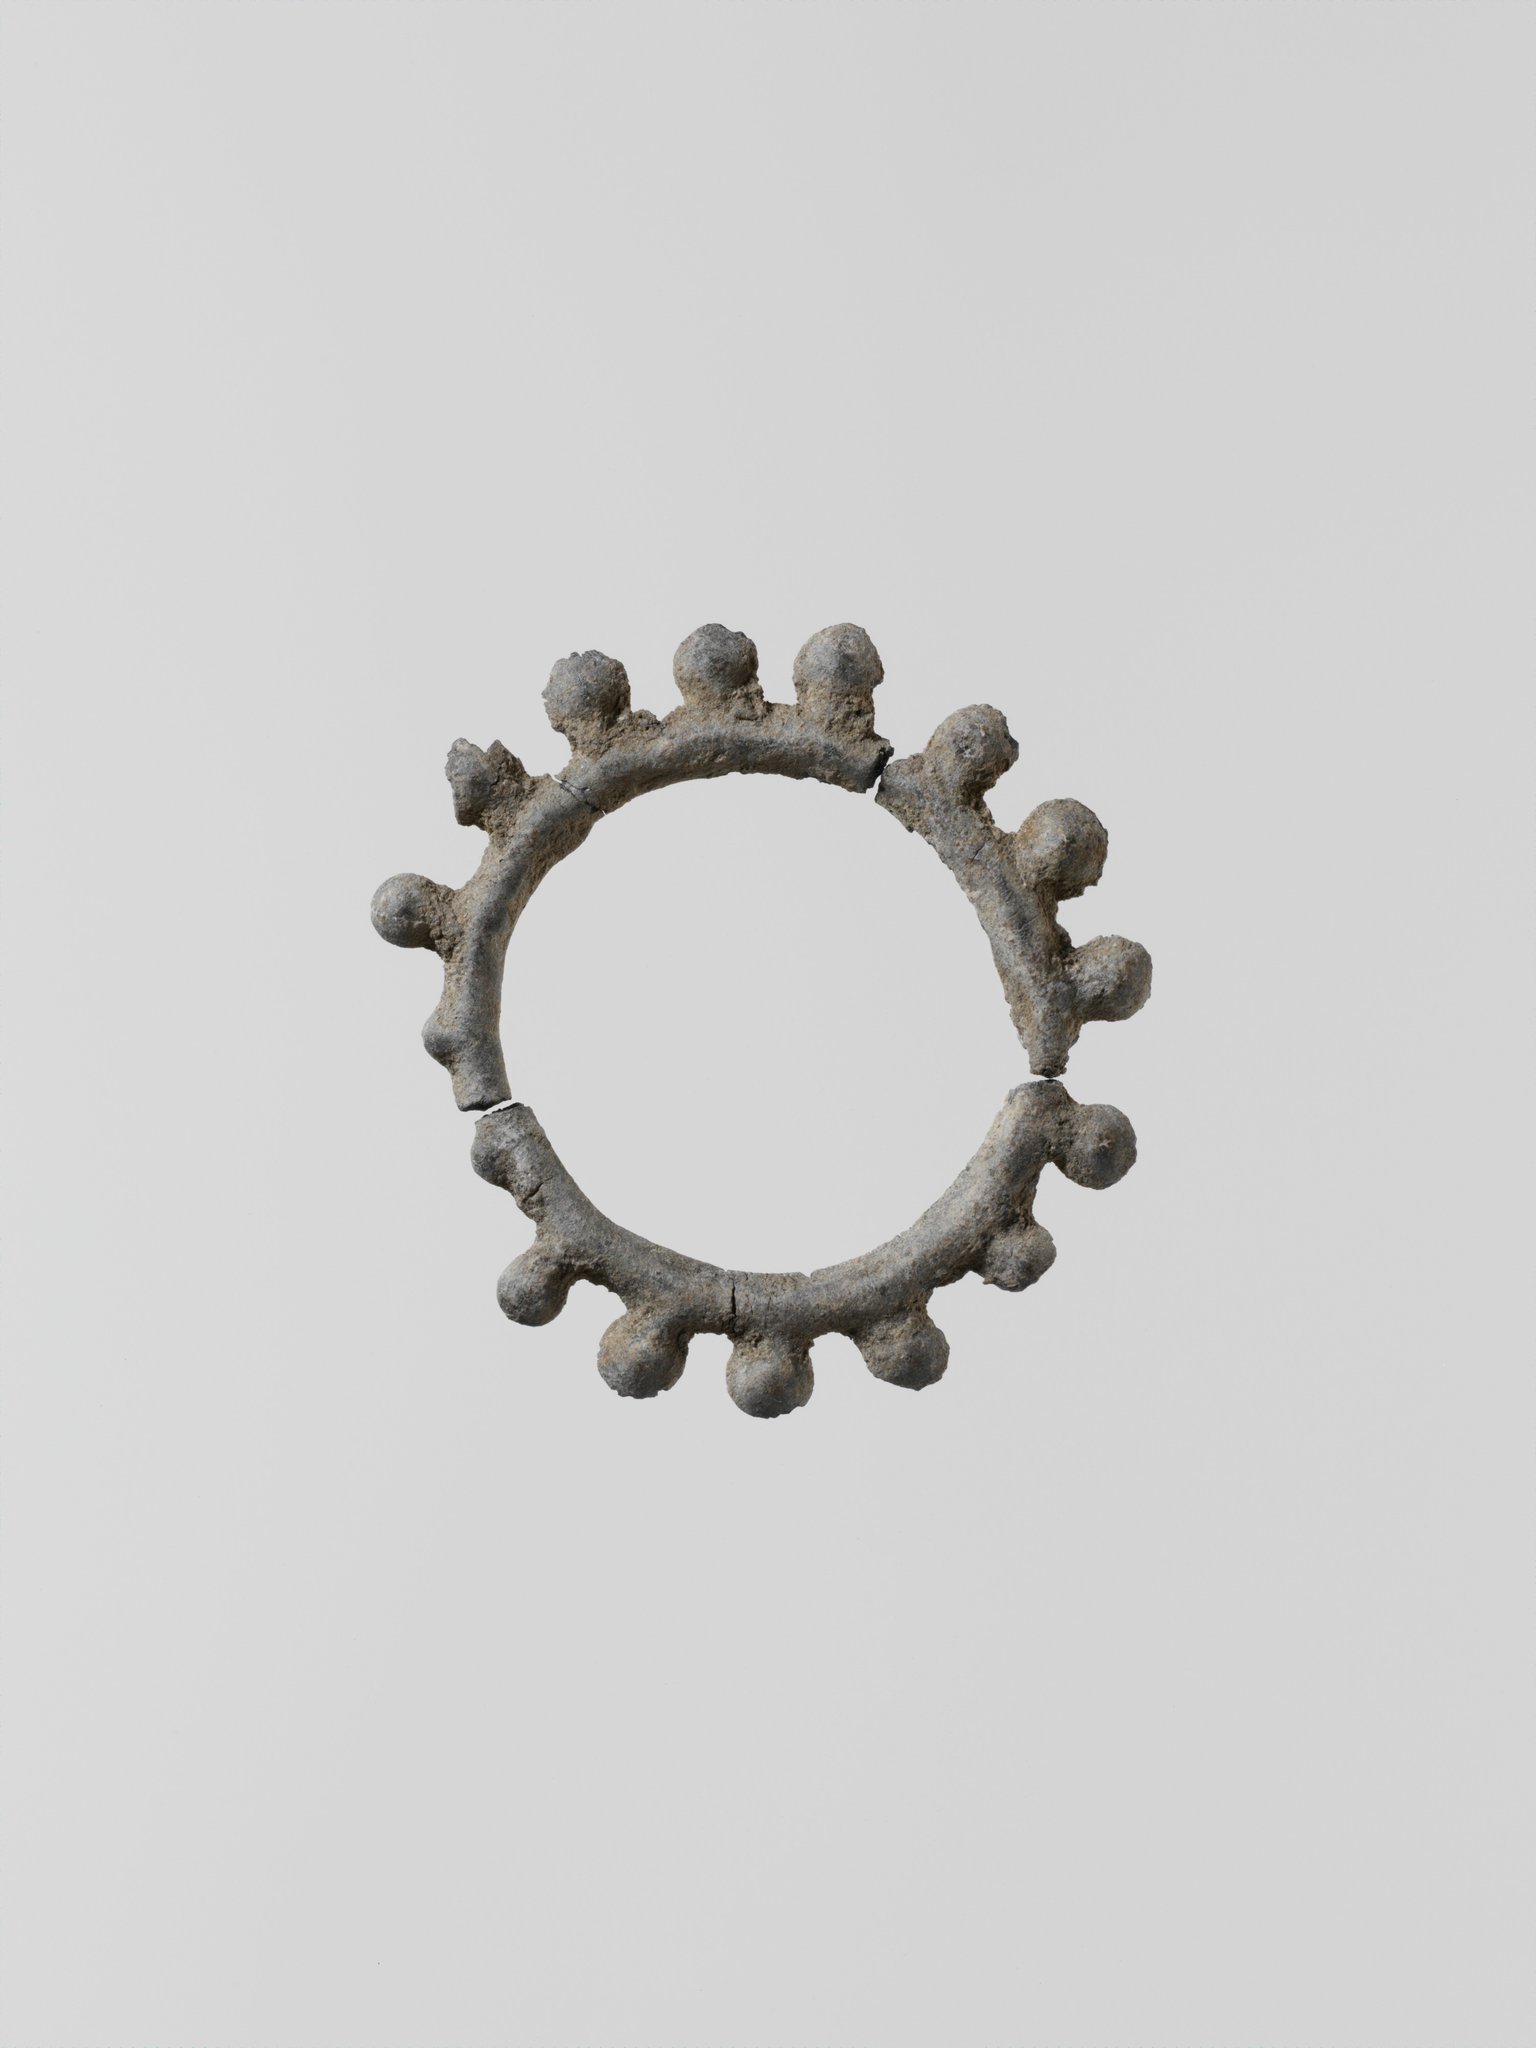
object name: wreath, 6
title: Wreaths, 6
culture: greek, laconian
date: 7000-30 BCE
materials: lead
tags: wreaths